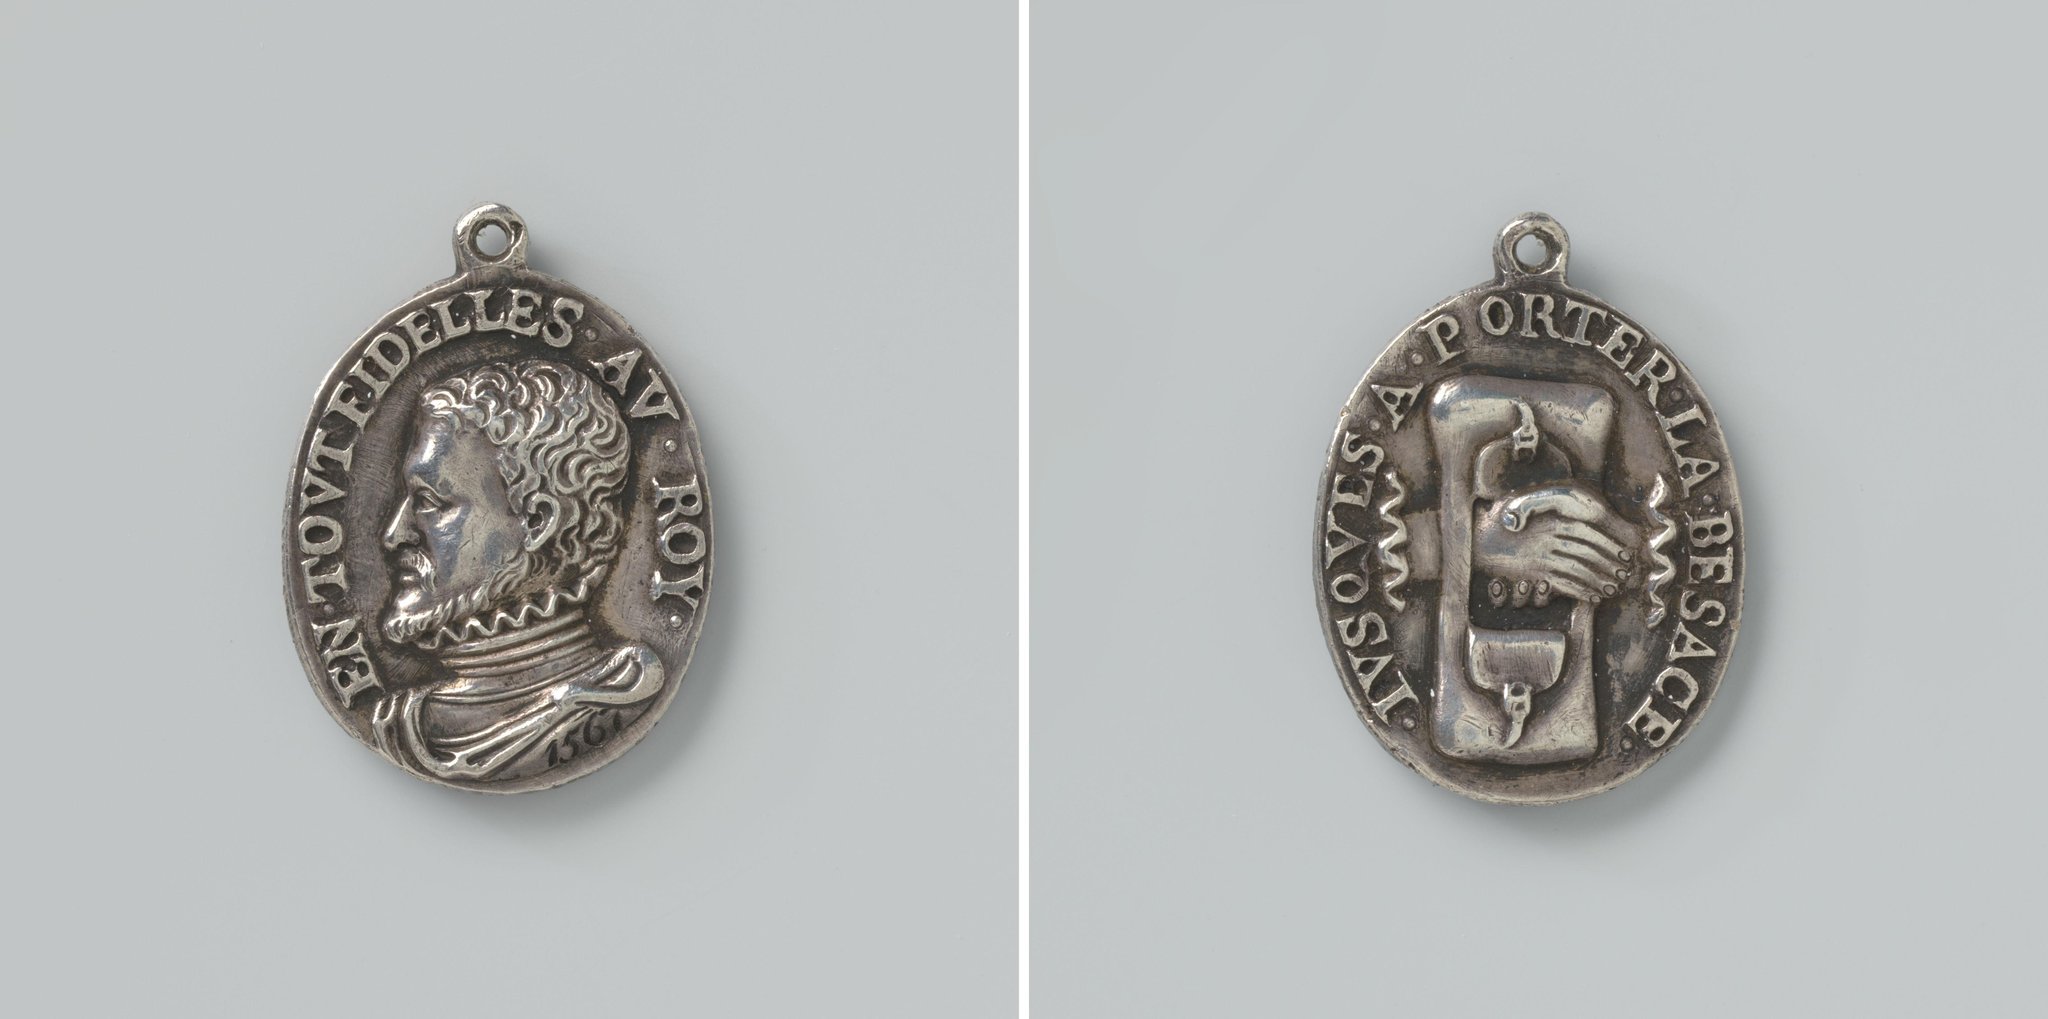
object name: medal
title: Geuzenpenning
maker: jacques jonghelinck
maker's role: medailleur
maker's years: 1530-1606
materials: silver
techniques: casting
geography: netherlands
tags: philip ii of spain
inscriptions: date: ‘1567’, circumscription: ‘IVSQVES.A.PORTER.LA.BESACE’, circumscription: ‘EN.TOVT.FIDELLES.AV.ROY’